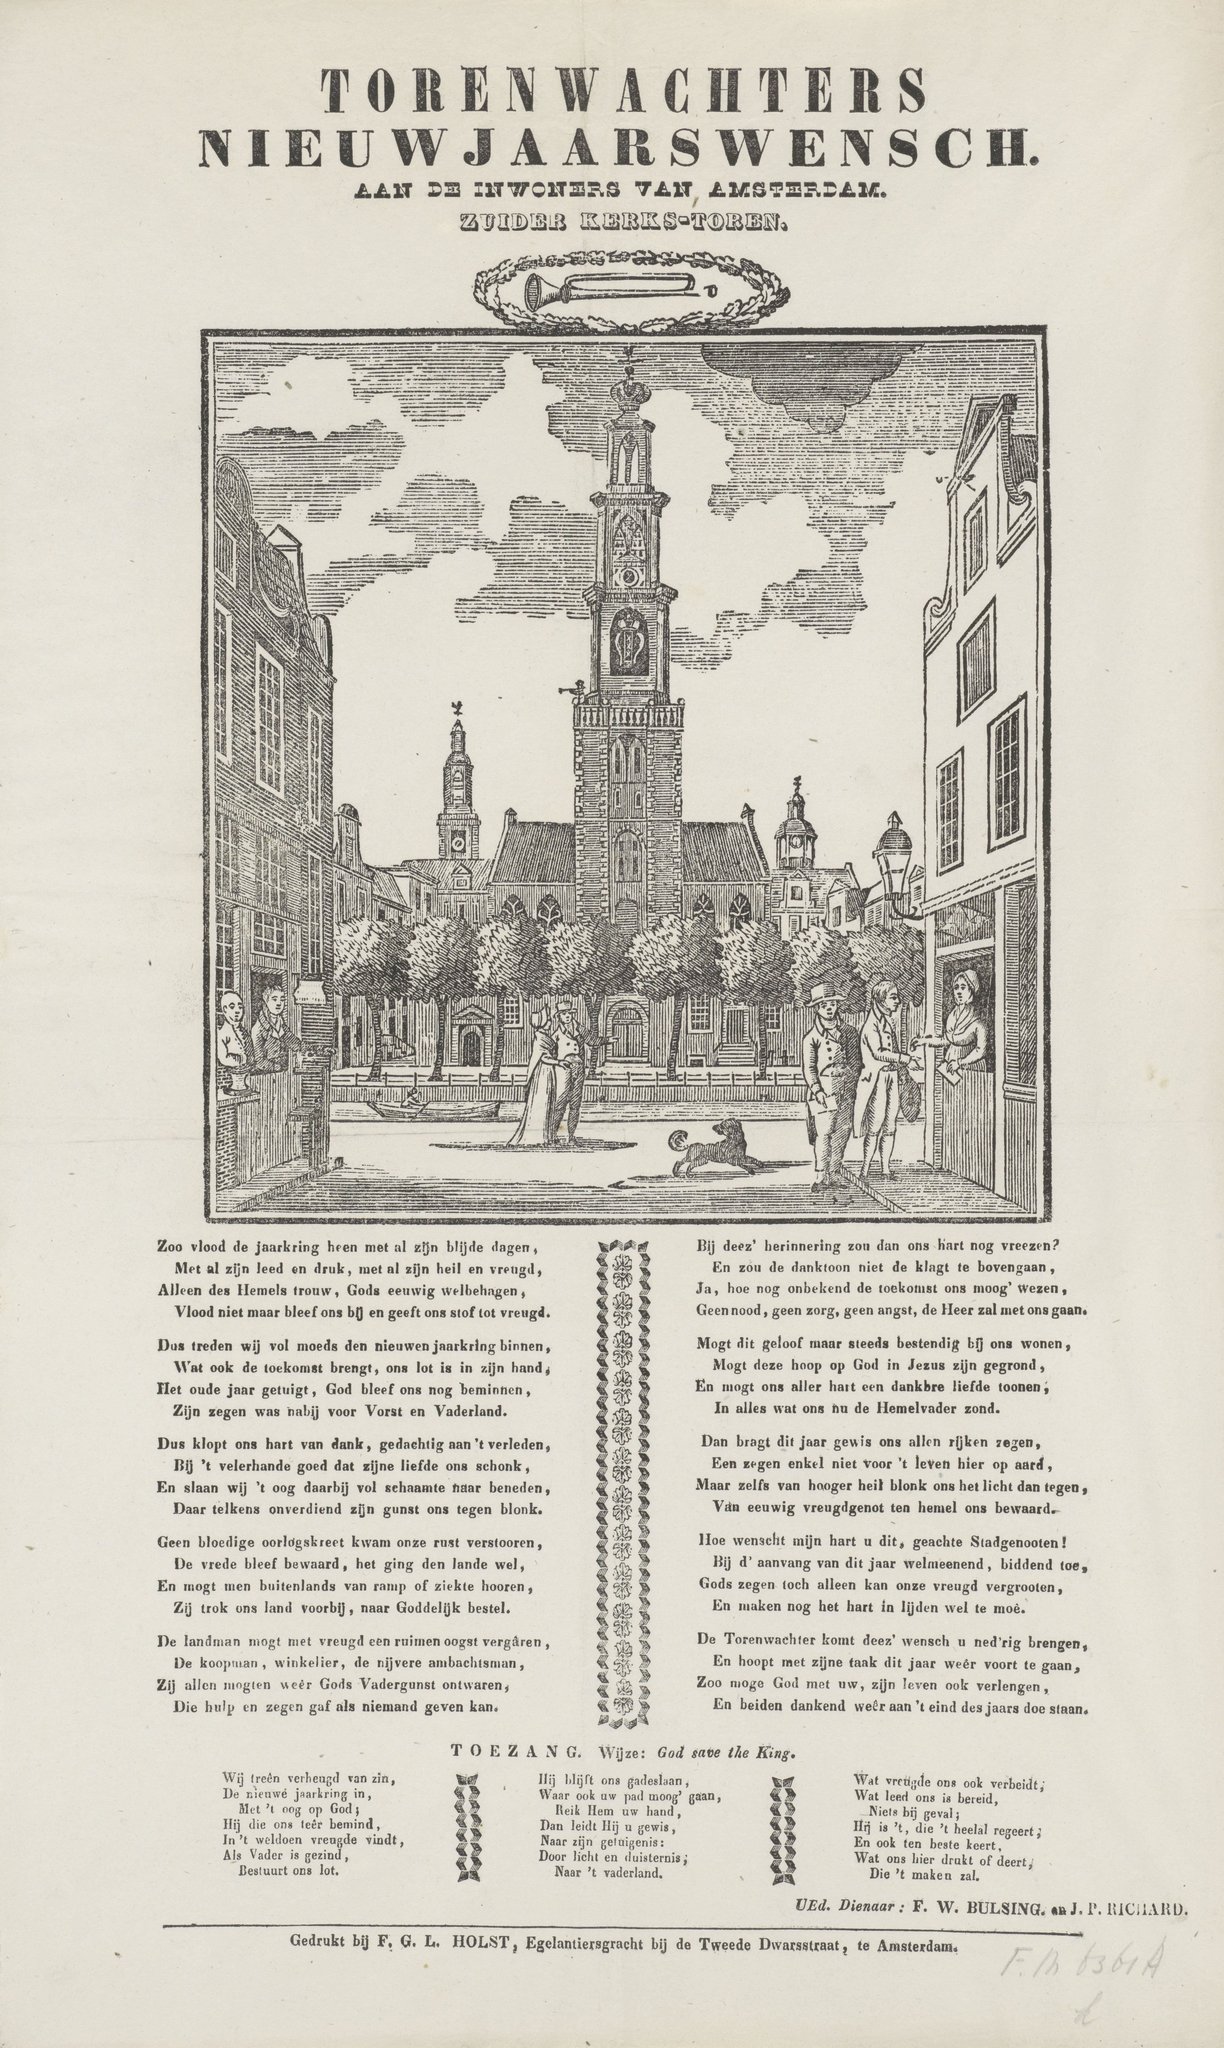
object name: new year card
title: Nieuwjaarswens van de torenwachters van de Zuiderkerk te Amsterdam, ca. 1840-1870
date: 1840-1870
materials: paper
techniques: letterpress printing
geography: amsterdam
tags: tower sentry, street, amsterdam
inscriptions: collector's mark: Lugt 2228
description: Nieuwjaarswens van de torenwachters van de Amsterdamse Zuiderkerk, ca. 1840-1870. Gezicht op de Westerkerk te Amsterdam, twee mannen halen aan de huizen geld op. Onderaan een gedicht in twee kolommen en een lied in drie verzen. Van de torenwachters: F.W. Bulsing en J.P. Richard.